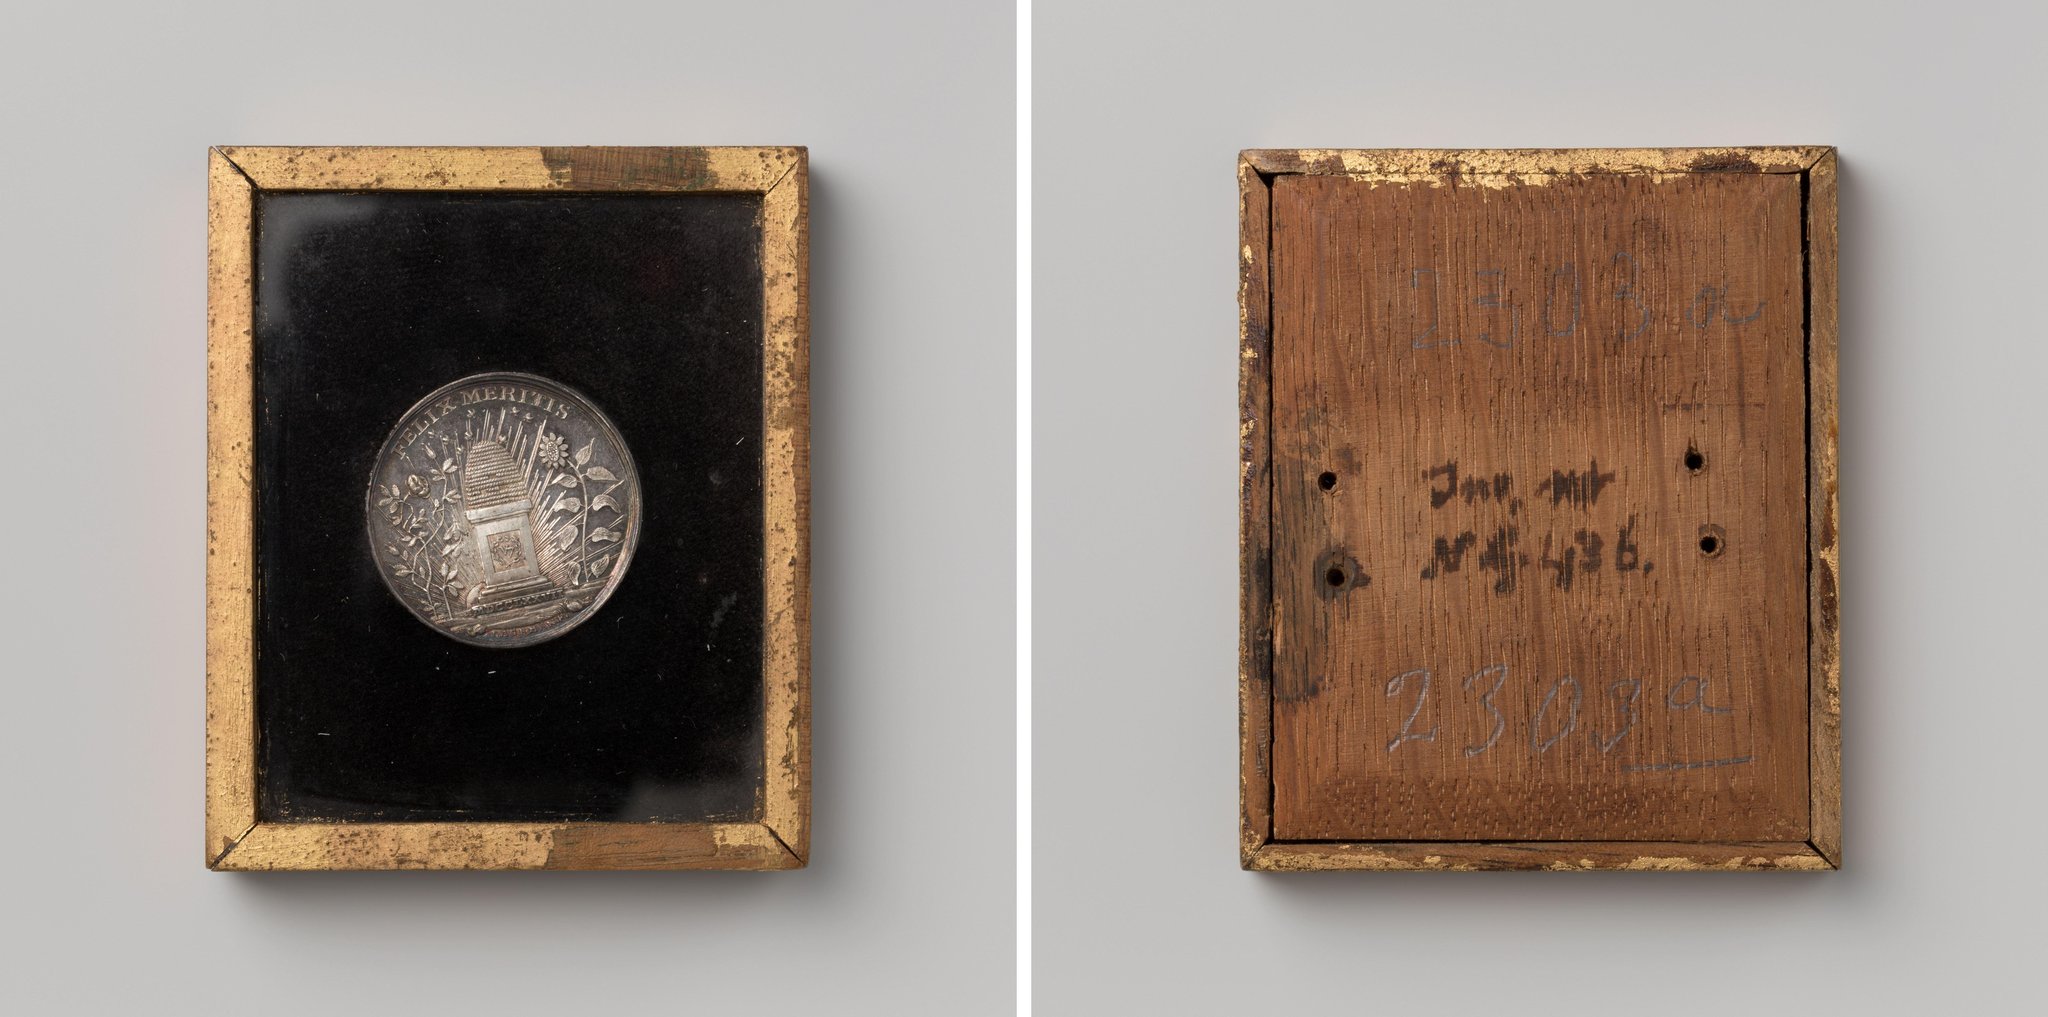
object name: history medal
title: Vijfentwintigjarig bestaan van het genootschap "Felix Meritis"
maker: johannes michiel lageman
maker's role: silversmith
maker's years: 1735-1809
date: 1802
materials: glass, silver, wood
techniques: striking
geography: amsterdam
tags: amsterdam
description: Zilveren penning in lijstje van verguld hout. Voorzijde: bijenkorf, staande op altaar tussen rozestruik en zonnebloem, beschenen door opgaande zon binnen omschrift; afsnede: signatuur. Keerzijde: [niet zichtbaar]: opschrift binnen bladerkrans.